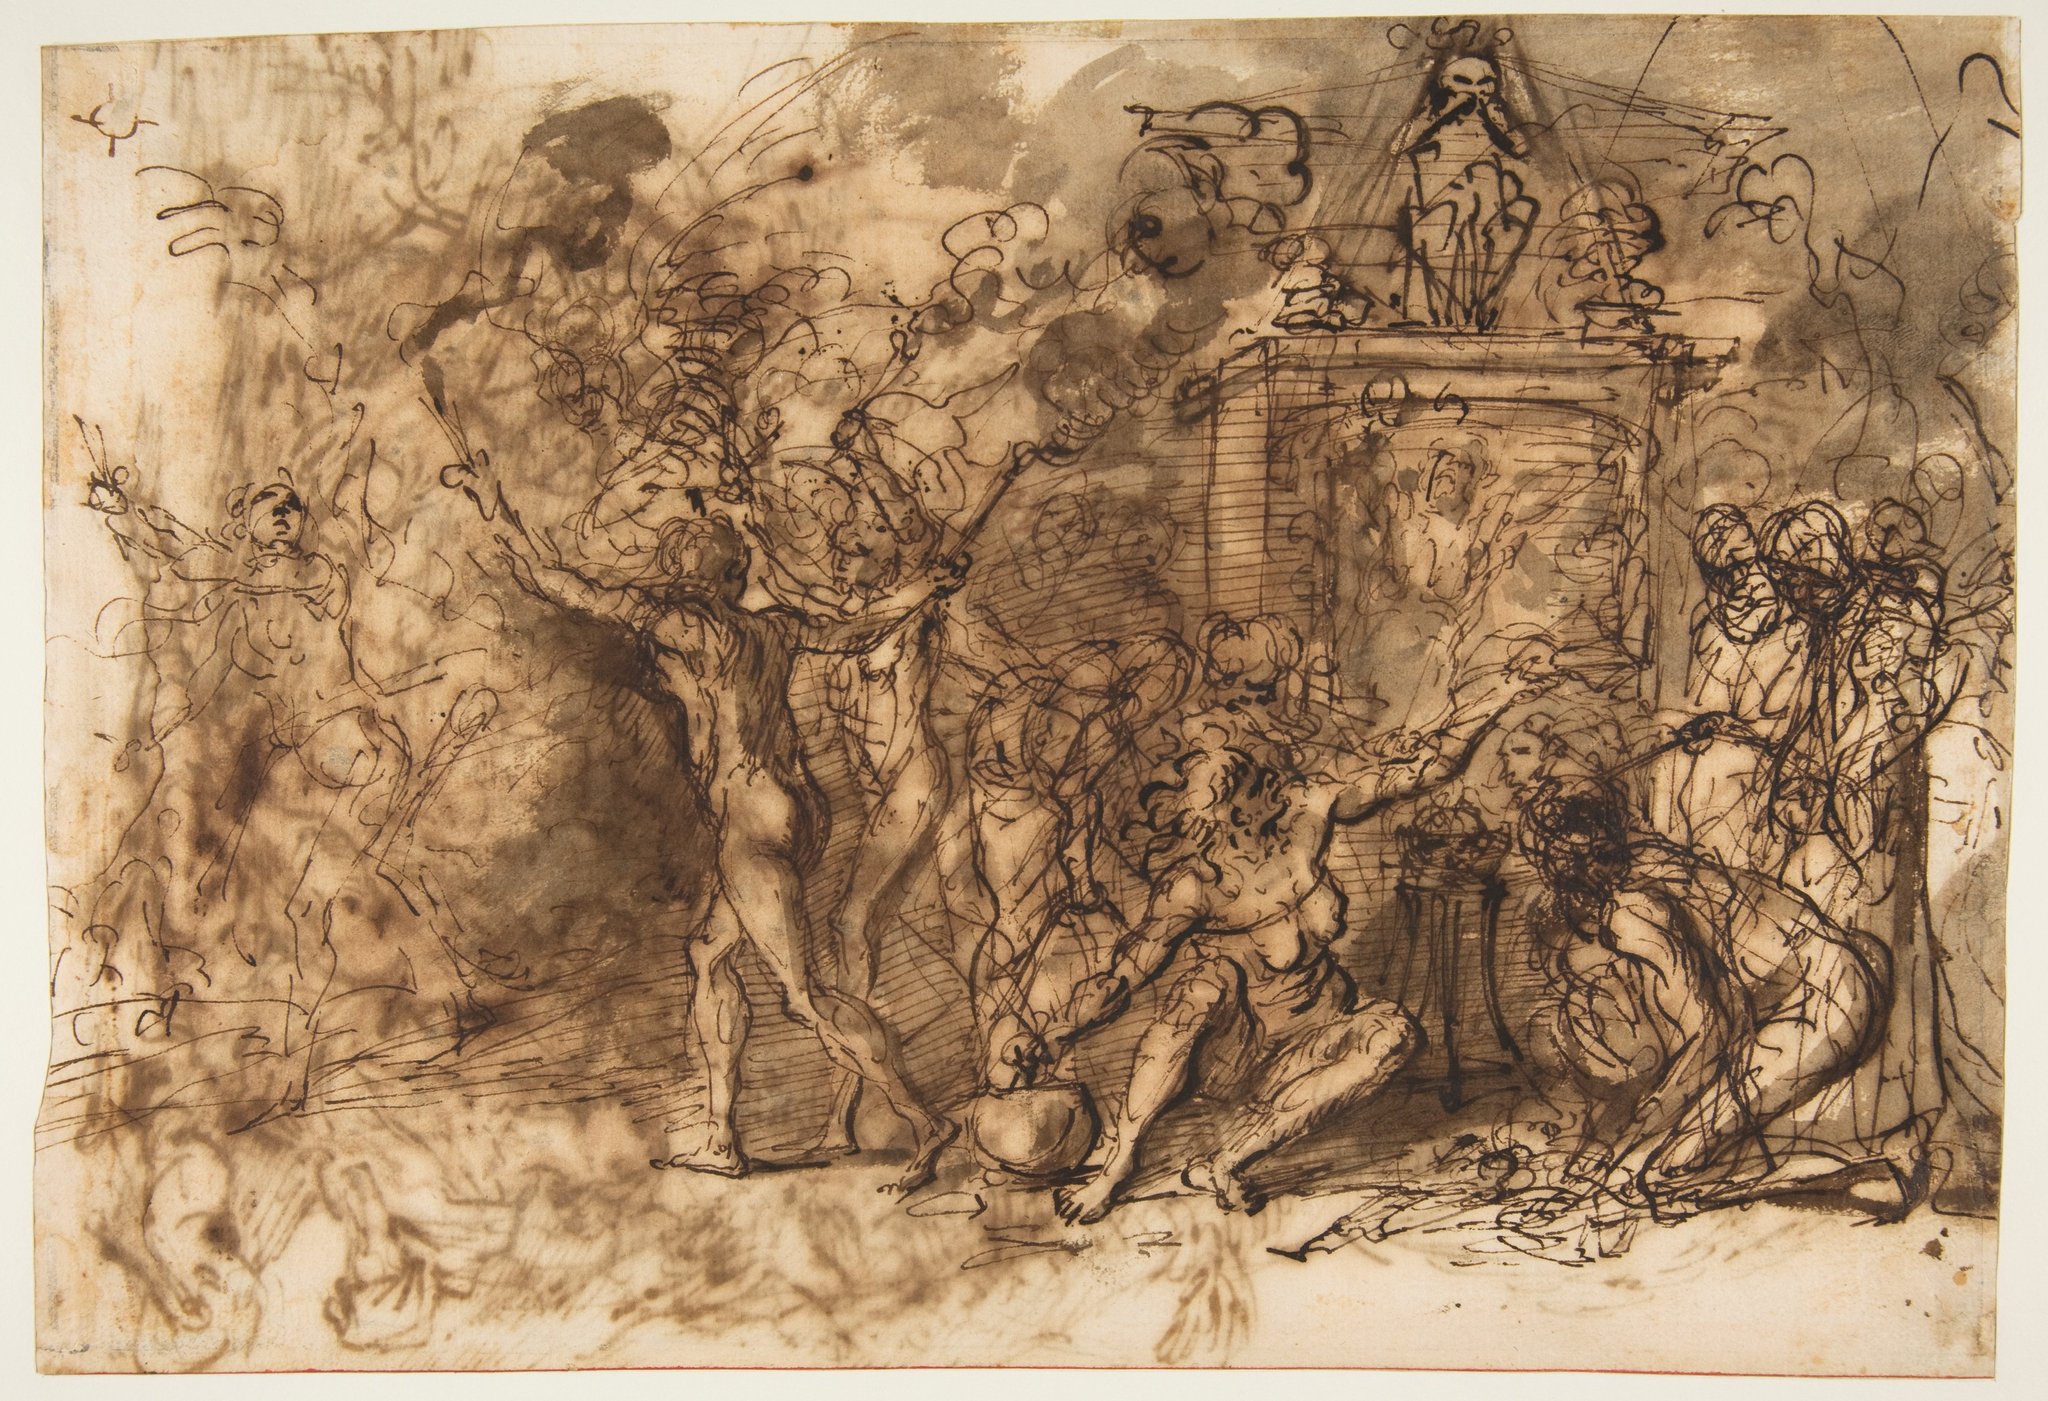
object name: drawing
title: Witches' Sabbath (recto); Figures Gathered around a tree (verso)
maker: salvator rosa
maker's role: artist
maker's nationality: italian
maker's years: 1615-1673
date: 1615-1673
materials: chalk, ink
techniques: brush, pen, wash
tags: female nudes,witches